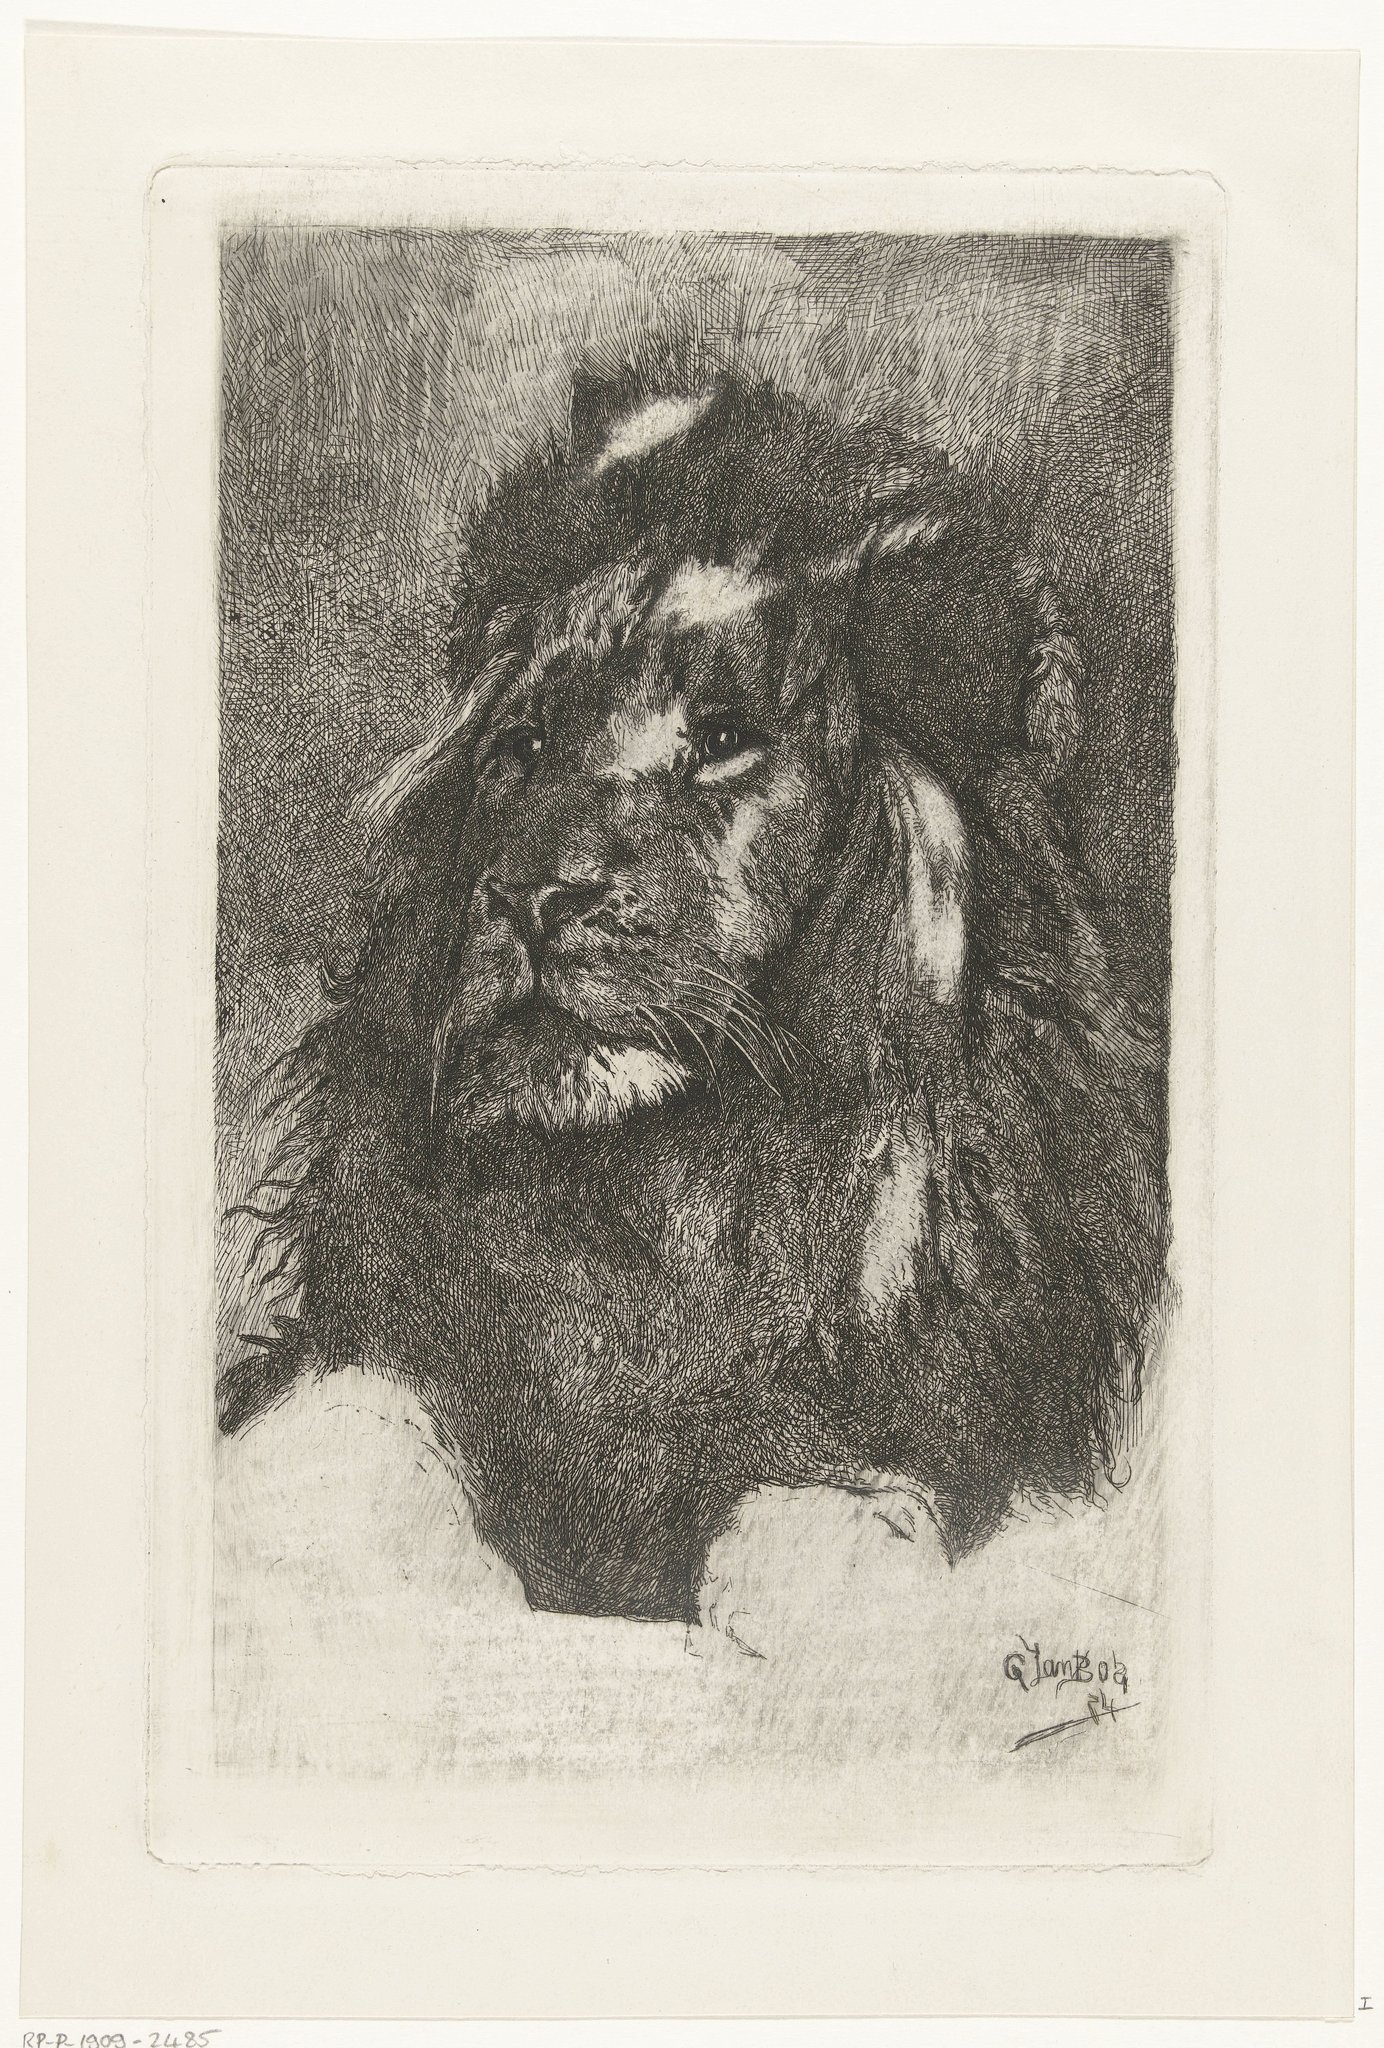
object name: print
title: Kop van een leeuw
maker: gerard jan bos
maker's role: print maker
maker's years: 1860-1943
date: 1884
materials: paper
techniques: etching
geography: antwerp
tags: beasts of prey, predatory animals: lion (+ head of an animal)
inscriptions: inscription: ‘Gouden medalje te Antwerpen Anno 1884’, collector's mark: Lugt 2228